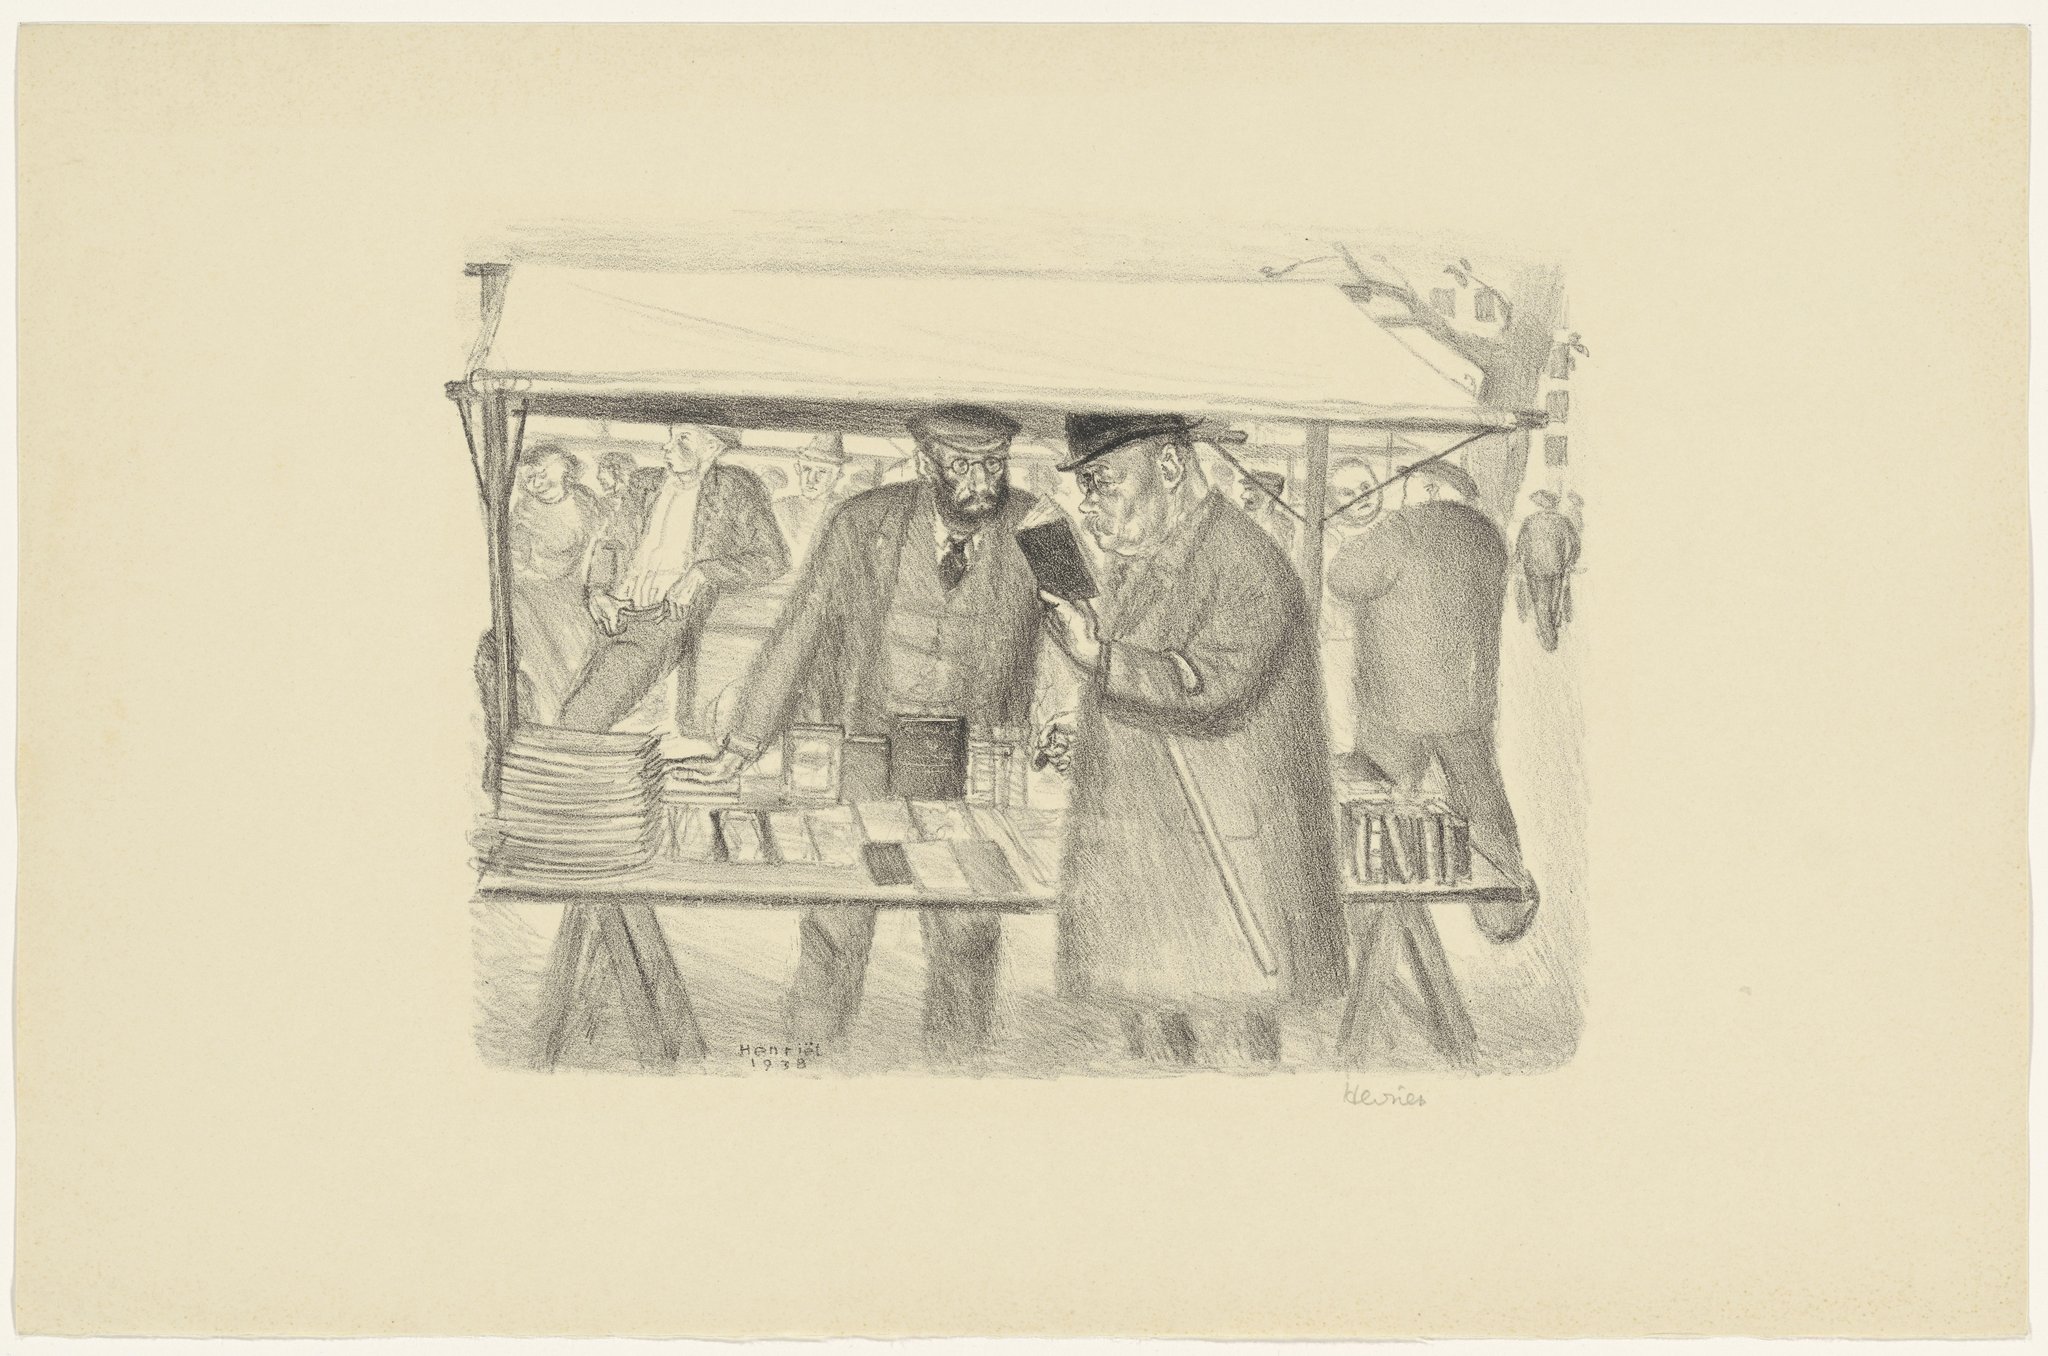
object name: print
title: Boekenstal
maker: henk henriët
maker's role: draughtsman, print maker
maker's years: 1903-1945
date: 1938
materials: paper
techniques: lithograph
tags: book-stall, kiosk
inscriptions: date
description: Een man met een bolhoed, sigaar en wandelstok staat voor de boekenstal en leest in een boek. De verkoper leunt naar voren vanachter zijn kraam.